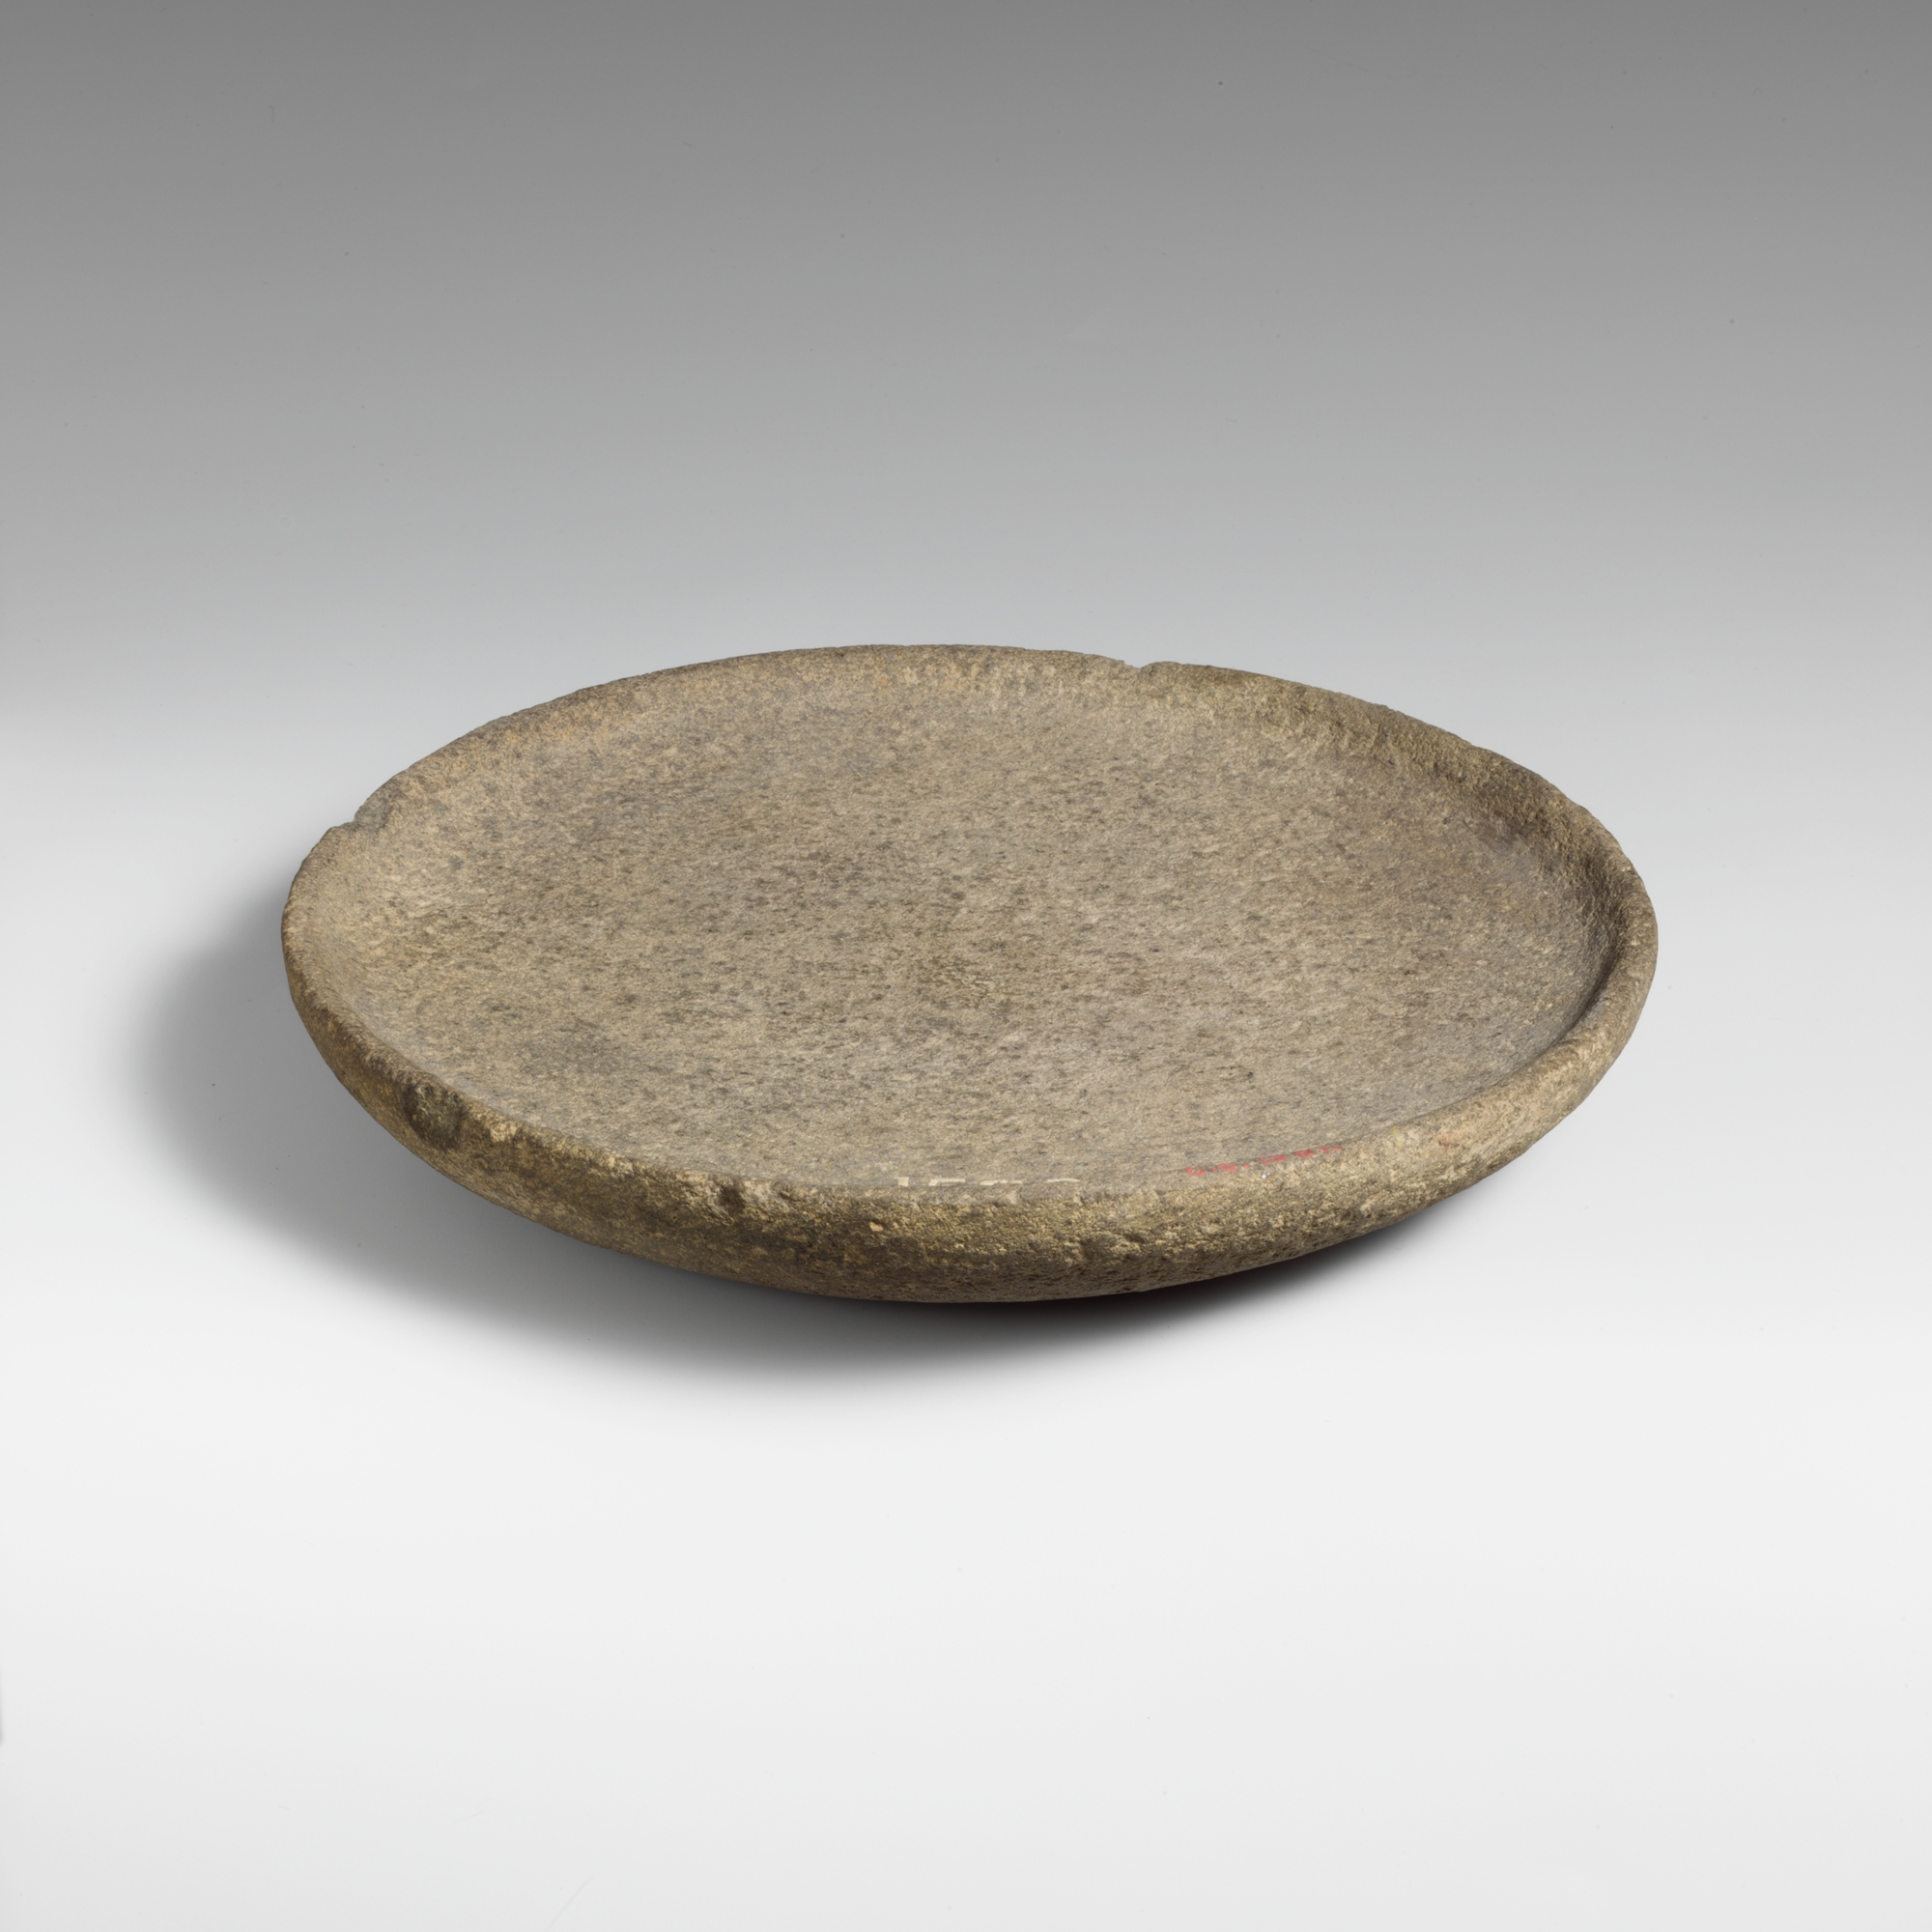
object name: plate or palette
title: Basalt mortar or plate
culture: cypriot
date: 1600-1050 BCE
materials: stone